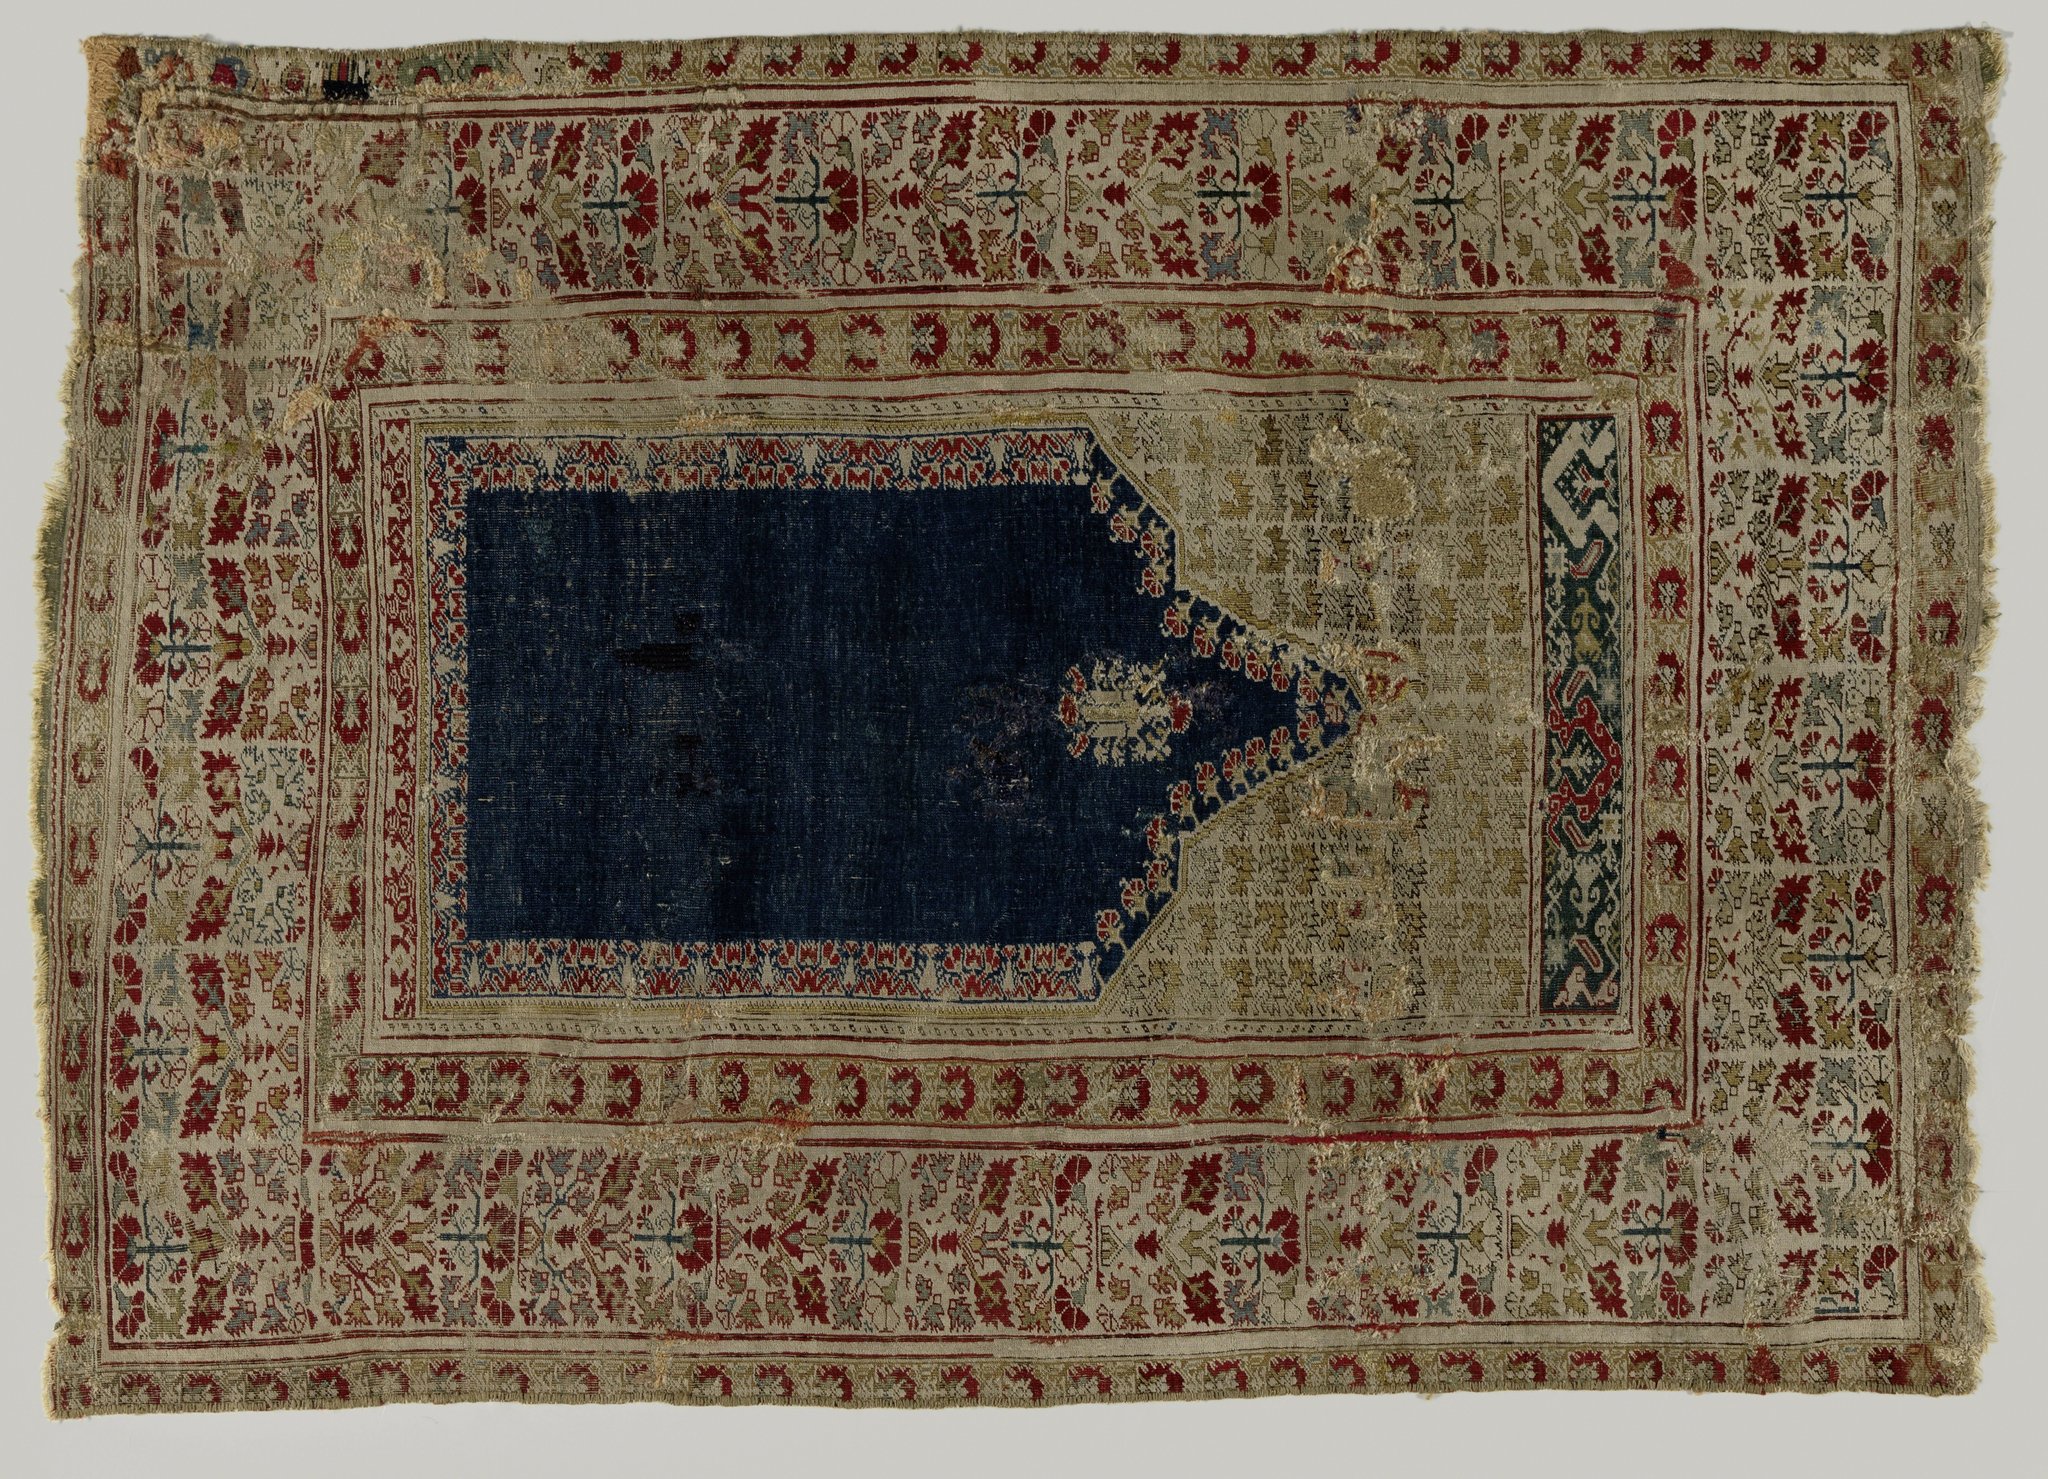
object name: prayer rug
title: Oosters tapijt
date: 1740-1760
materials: wool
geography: ghiordes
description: Oosters tapijt, bidkleed, van geknoopte wol, versierd met een korenblauwe mihrab, spitse en getande top, waarin een gestileerde lamp hangt. Beige zwikken met plantaanbladeren. Rond het middenveld drie randen en effen grijze tussenzomen.